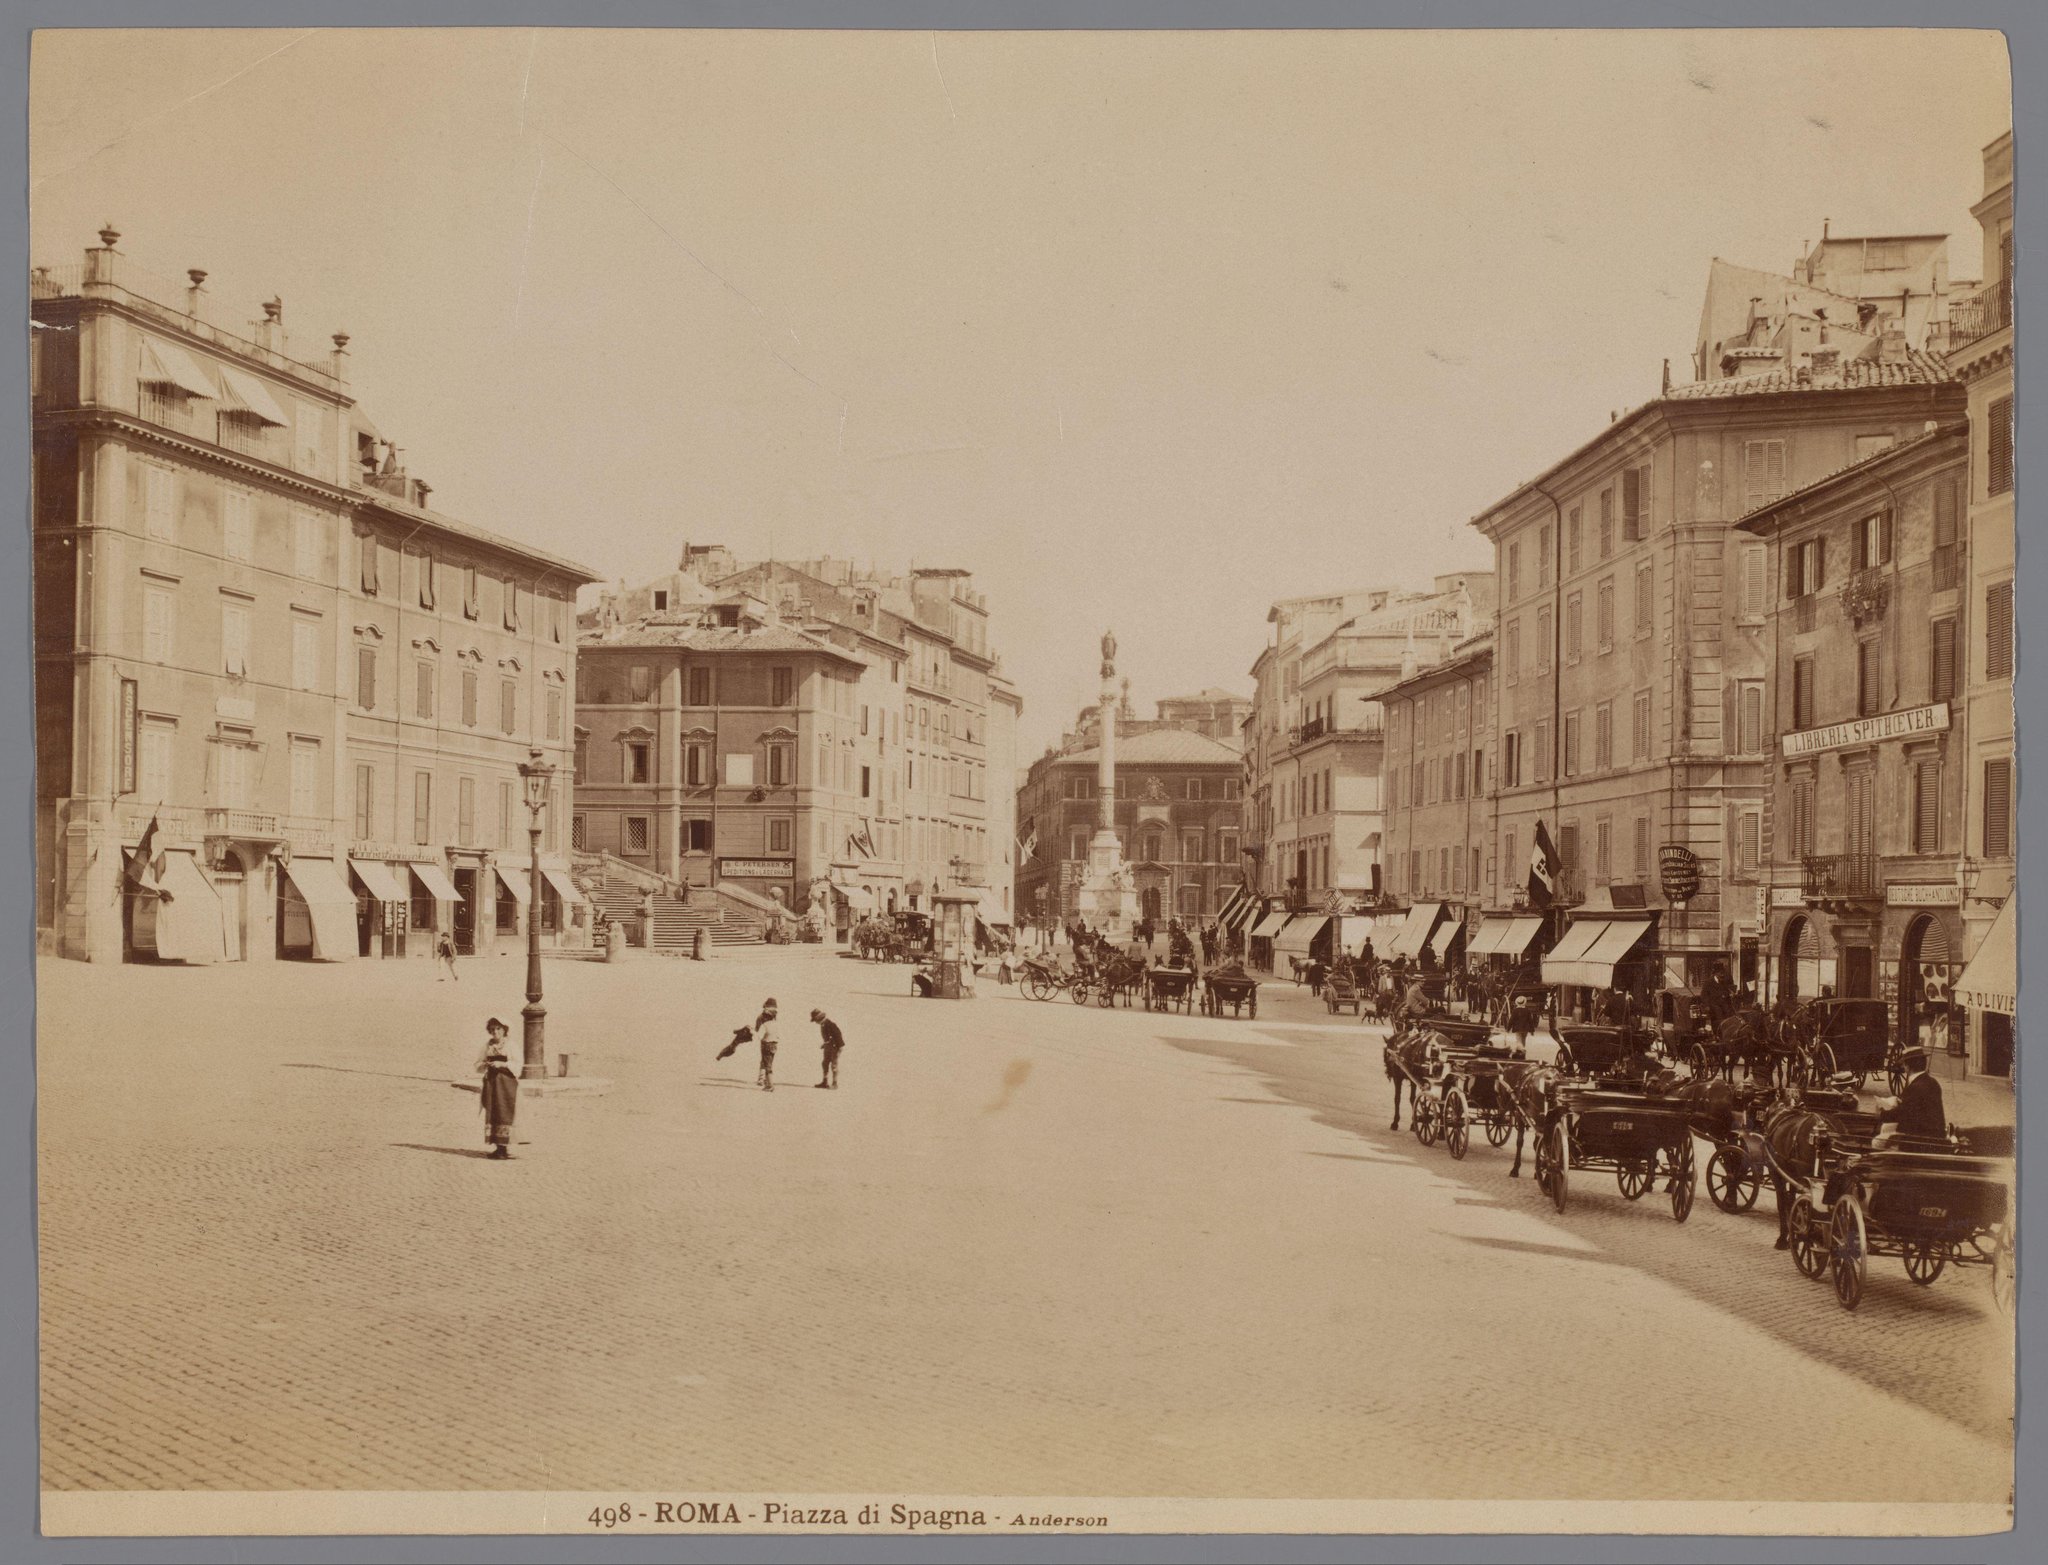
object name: photograph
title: Gezicht op het Piazza di Spagna in Rome, in de verte de Zuil van de Onbevlekte Ontvangenis en de Spaanse Trappen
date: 1860-1900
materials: cardboard, paper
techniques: albumen print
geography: rome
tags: square, place, circus, etc.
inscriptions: number: ‘498’, inscription: ‘Item # 421/ 45x/ gekocht augustus 1971 uit catalogus no 1 Jerry R R[...]/ New York/ $ 3.50’